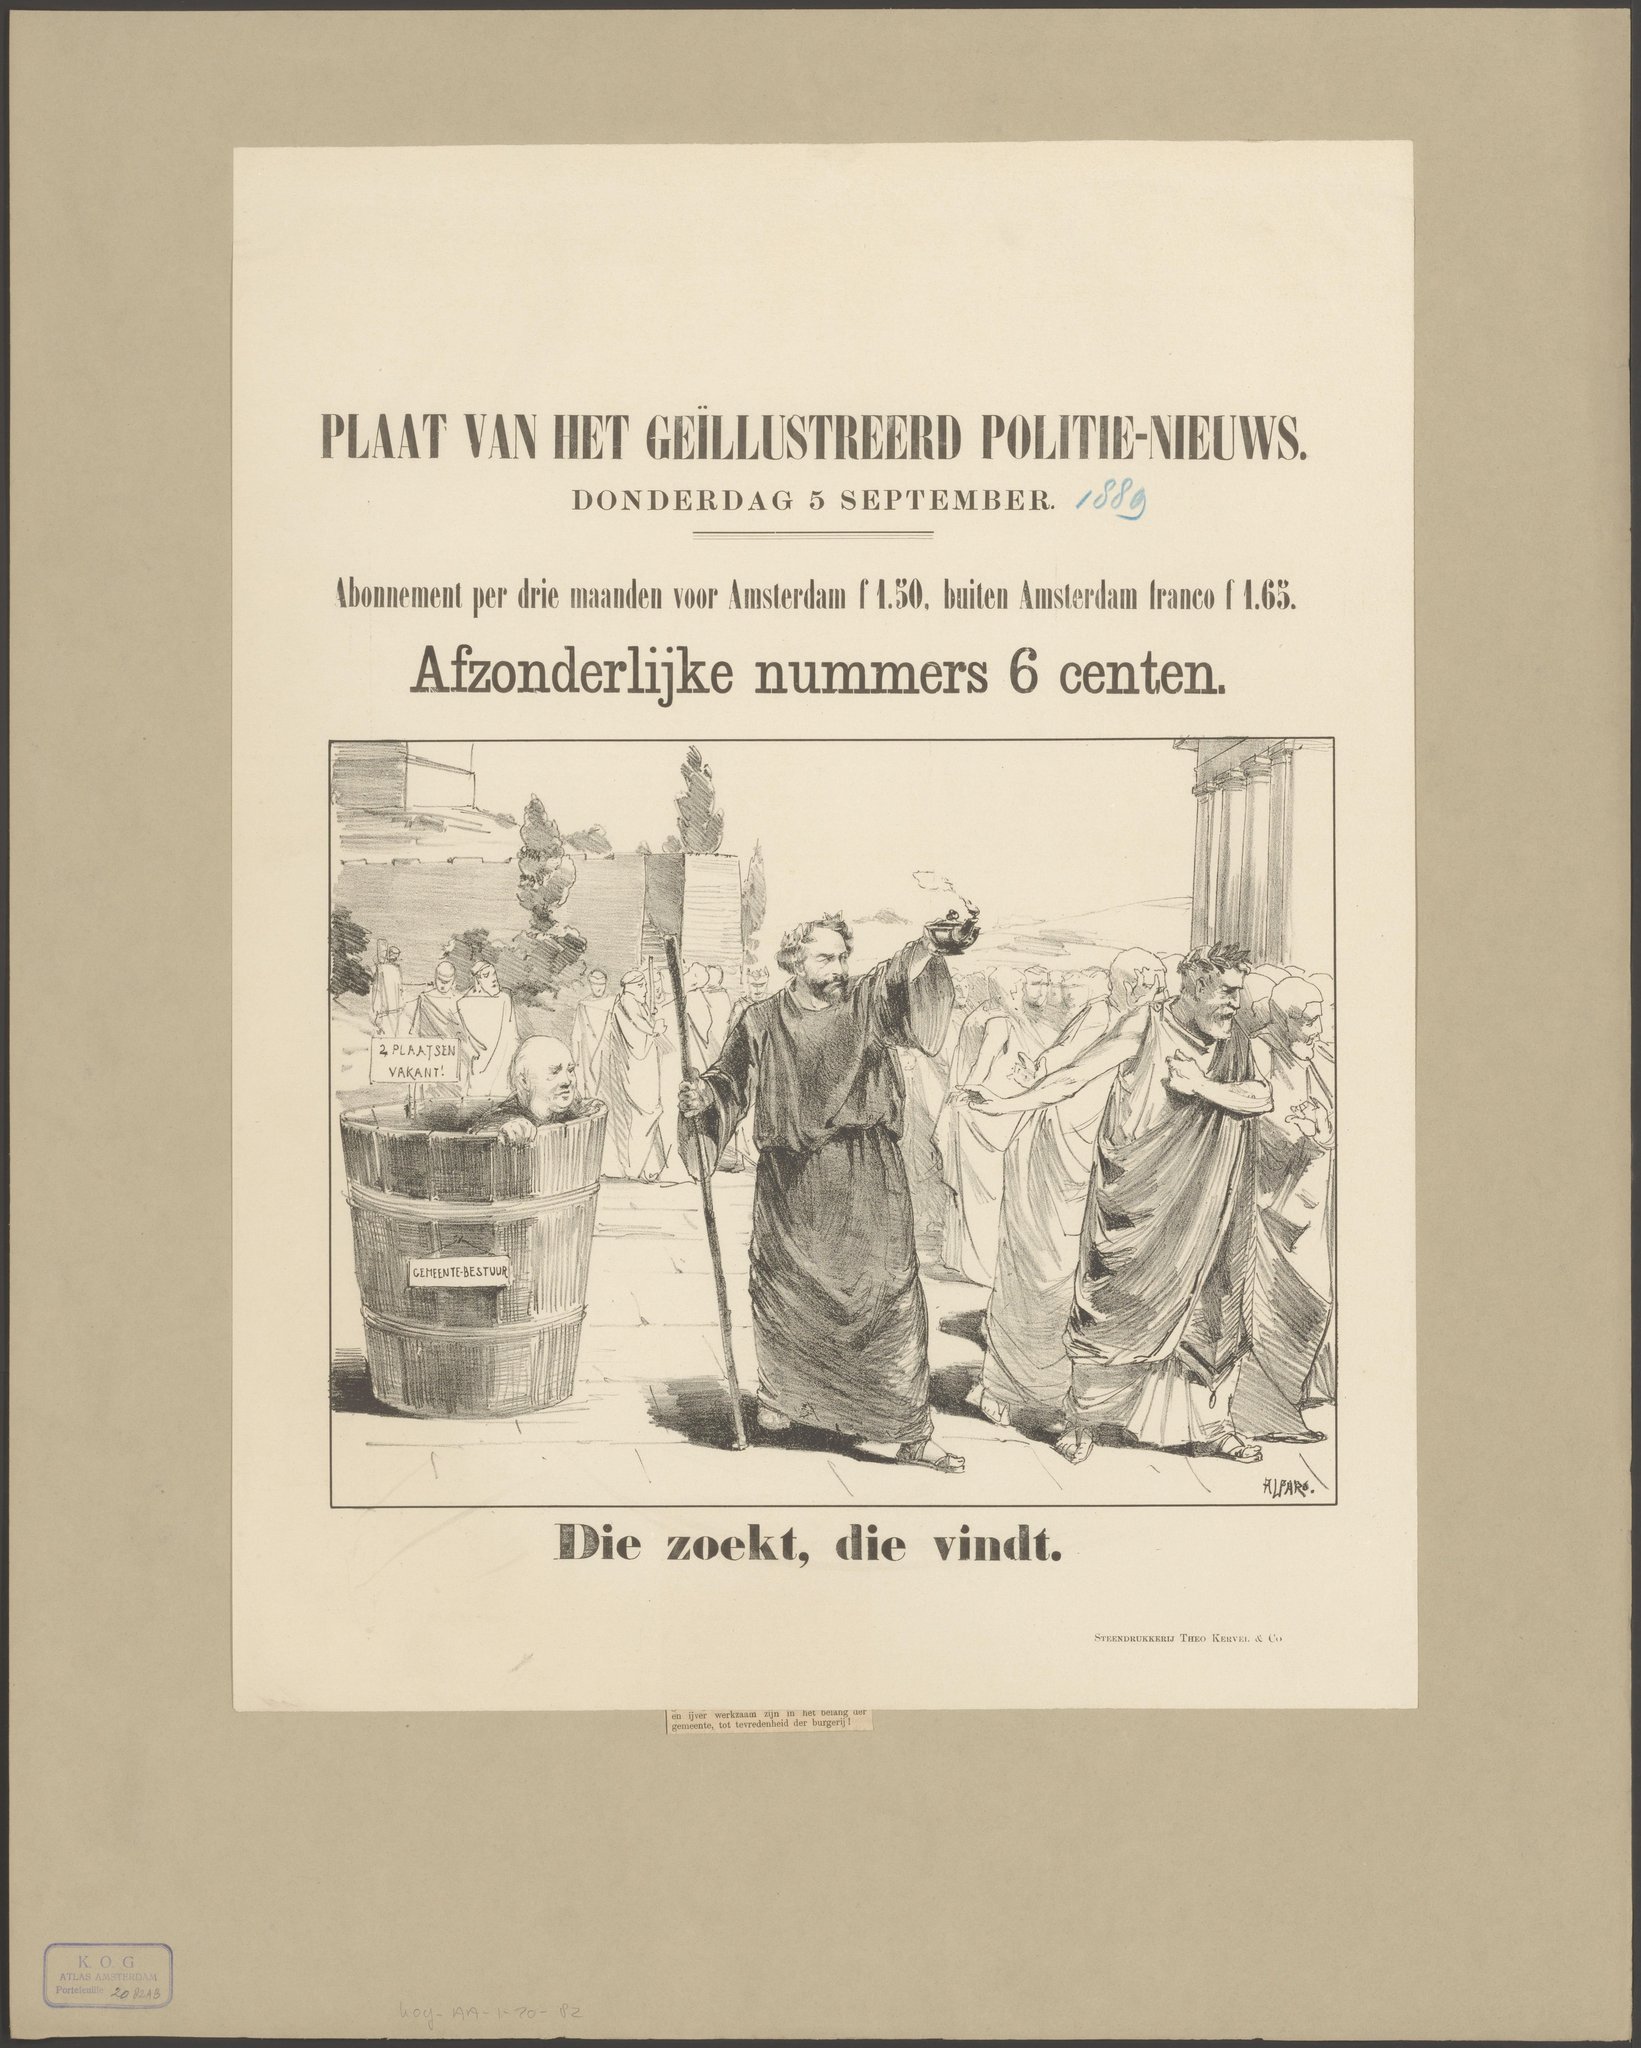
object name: cartoon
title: Gijsbert van Tienhoven als Diogenes die een oprechte mens zoekt en gemeden wordt door omstanders in antieke klederdracht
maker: alfaro reijding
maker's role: draughtsman, engineer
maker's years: 1863-1930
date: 1889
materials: paper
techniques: letterpress printing, lithograph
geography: amsterdam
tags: mayor, gijsbert van tienhoven, wooden container: barrel, cask, bucket, diogenes, carrying a lighted lantarn by daylight, trying to find an honest man, usually in a crowded market-place, political caricatures and satires, amsterdam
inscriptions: collector's mark: Lugt 1641b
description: Gepubliceerd als bijvoegsel van 'Geïllustreerd Politie-Nieuws', 5 september 1889.